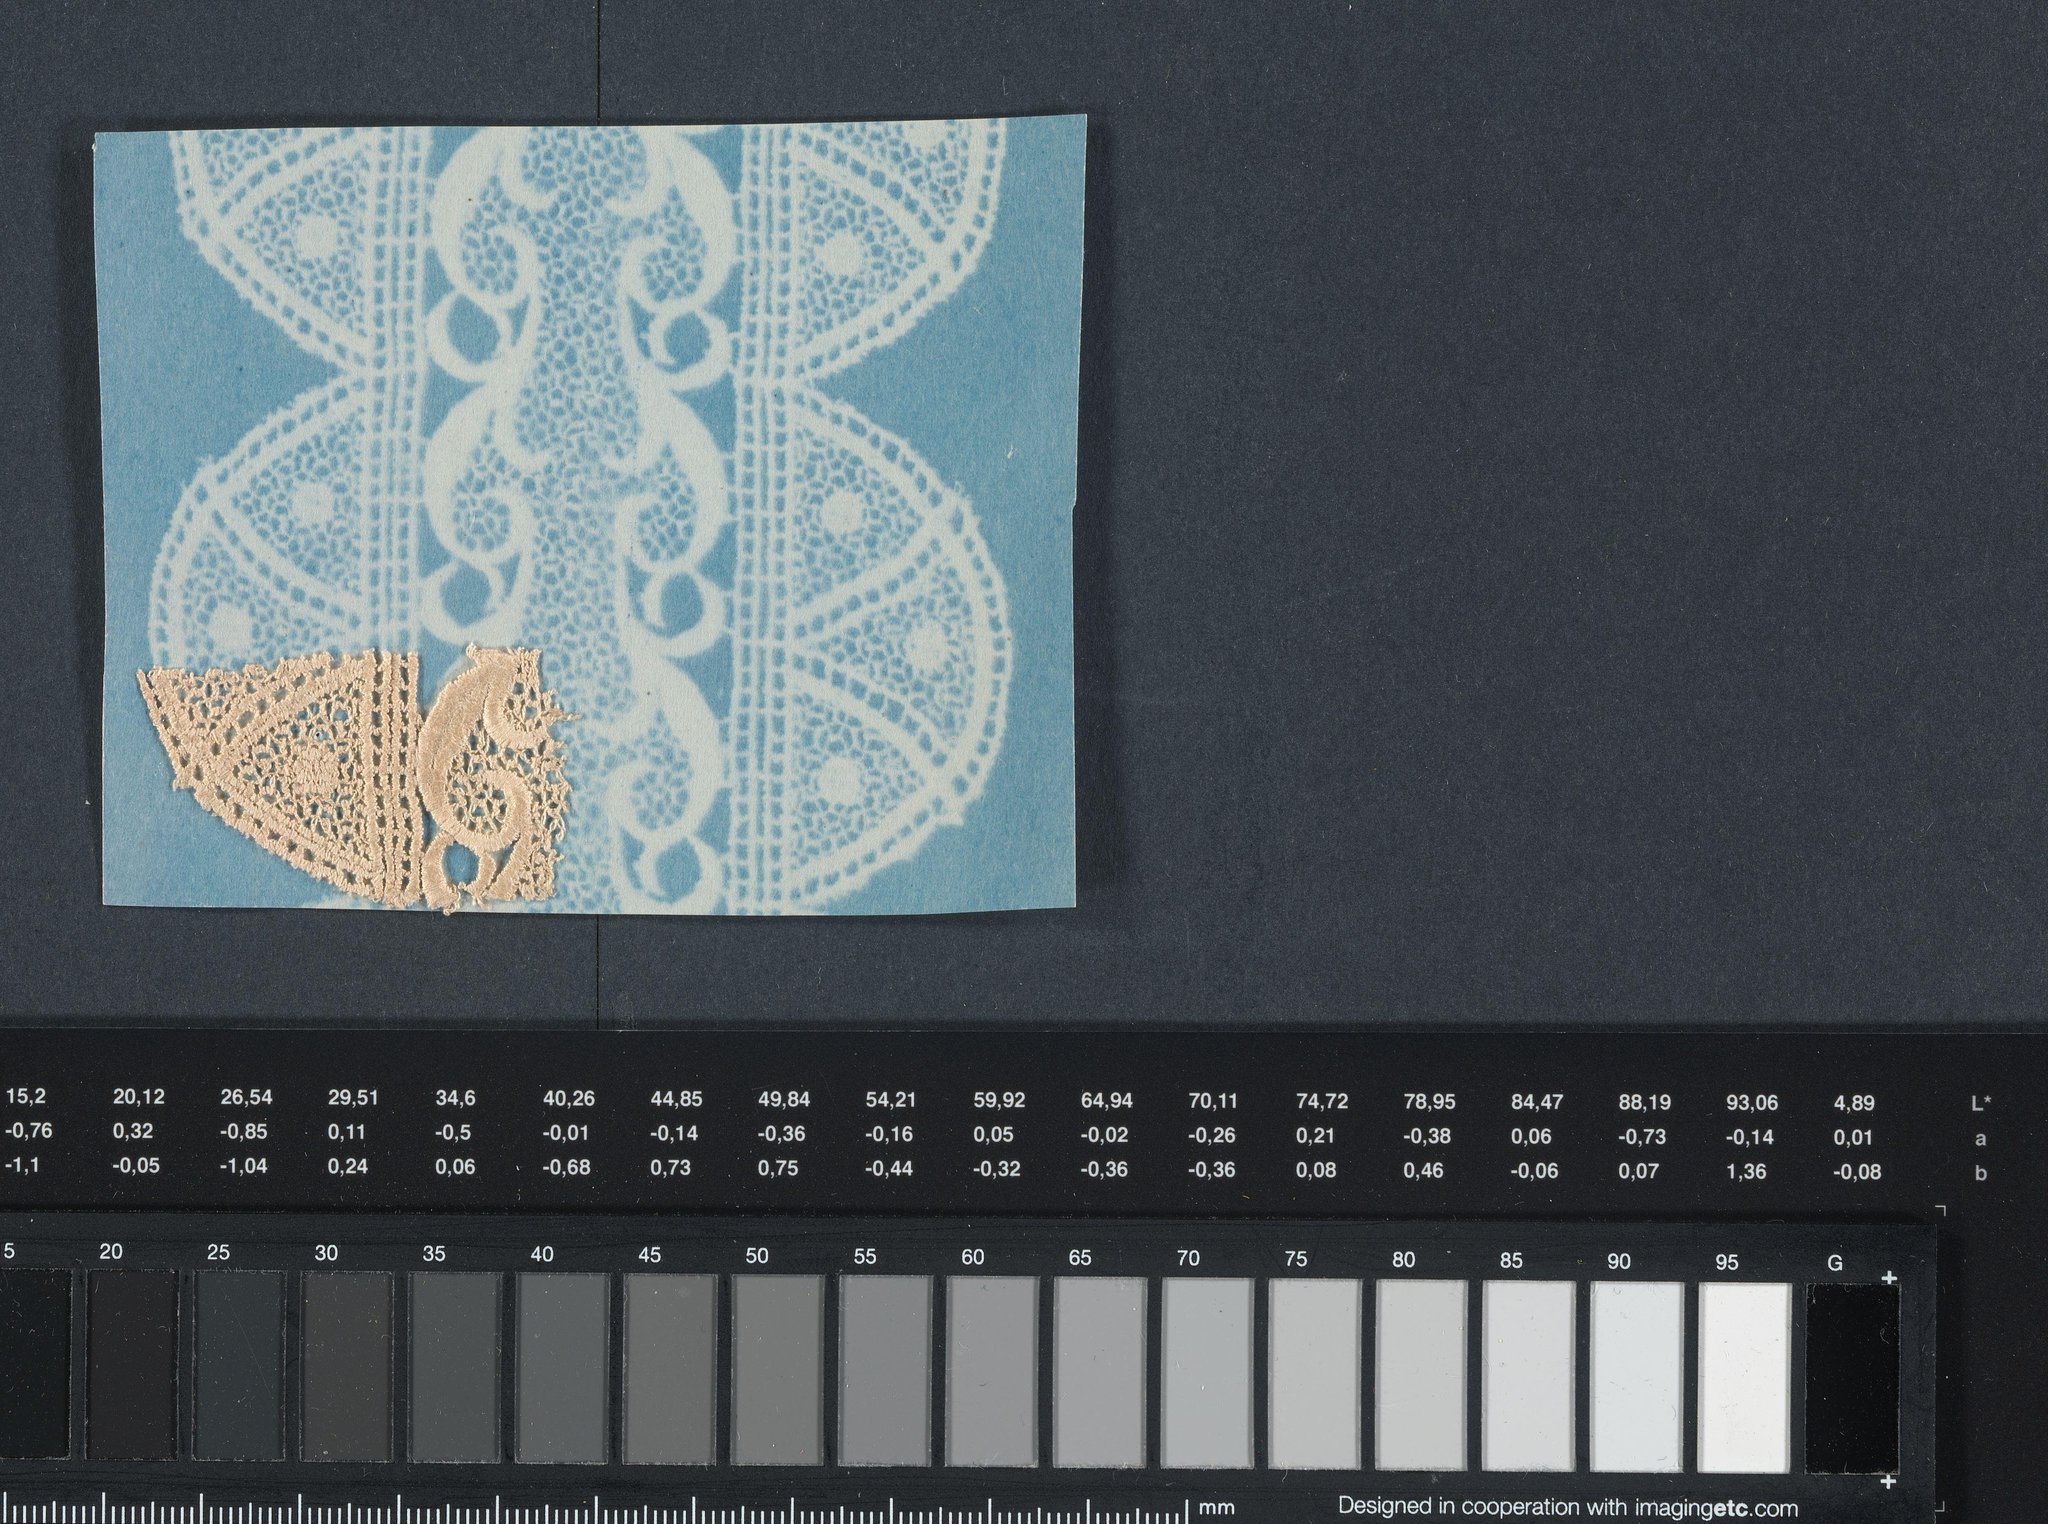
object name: photogram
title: Kant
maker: Anonymous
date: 1900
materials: paper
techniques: cyanotype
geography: france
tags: lace